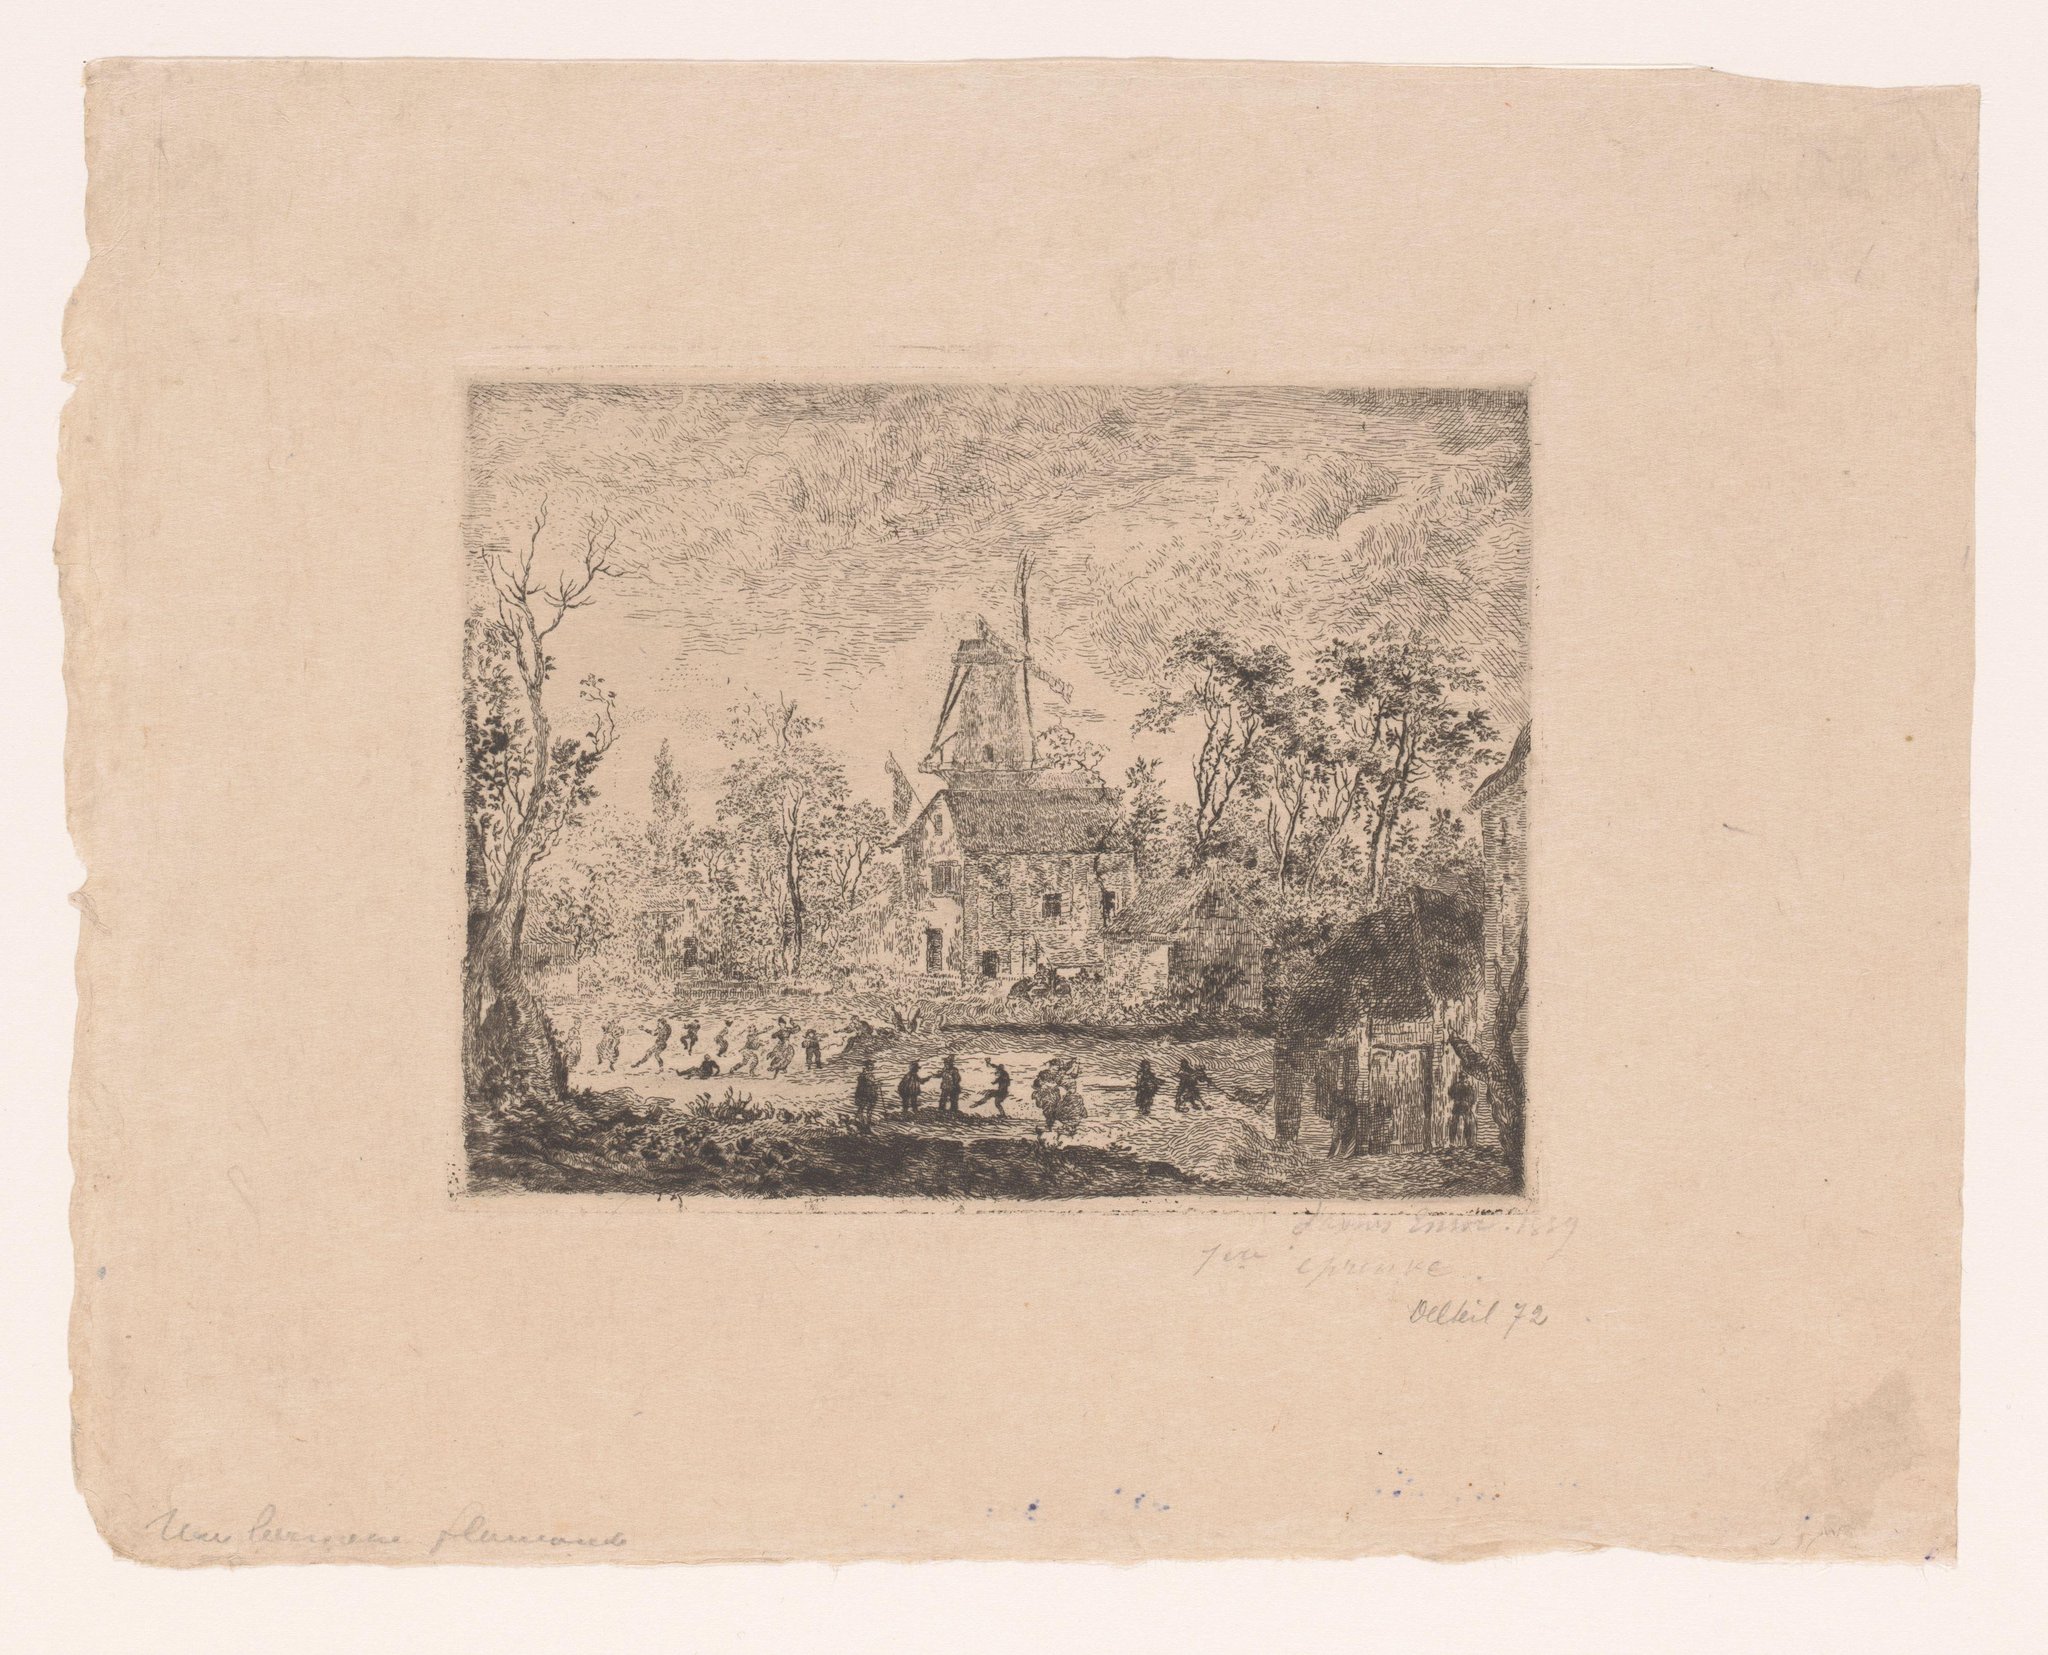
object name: print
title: La kermesse au moulin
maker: james ensor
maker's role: print maker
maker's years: 1860-1949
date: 1889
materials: paper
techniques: drypoint, etching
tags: windmill in landscape, pleasure fair and circus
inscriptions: collector's mark: Lugt 2228